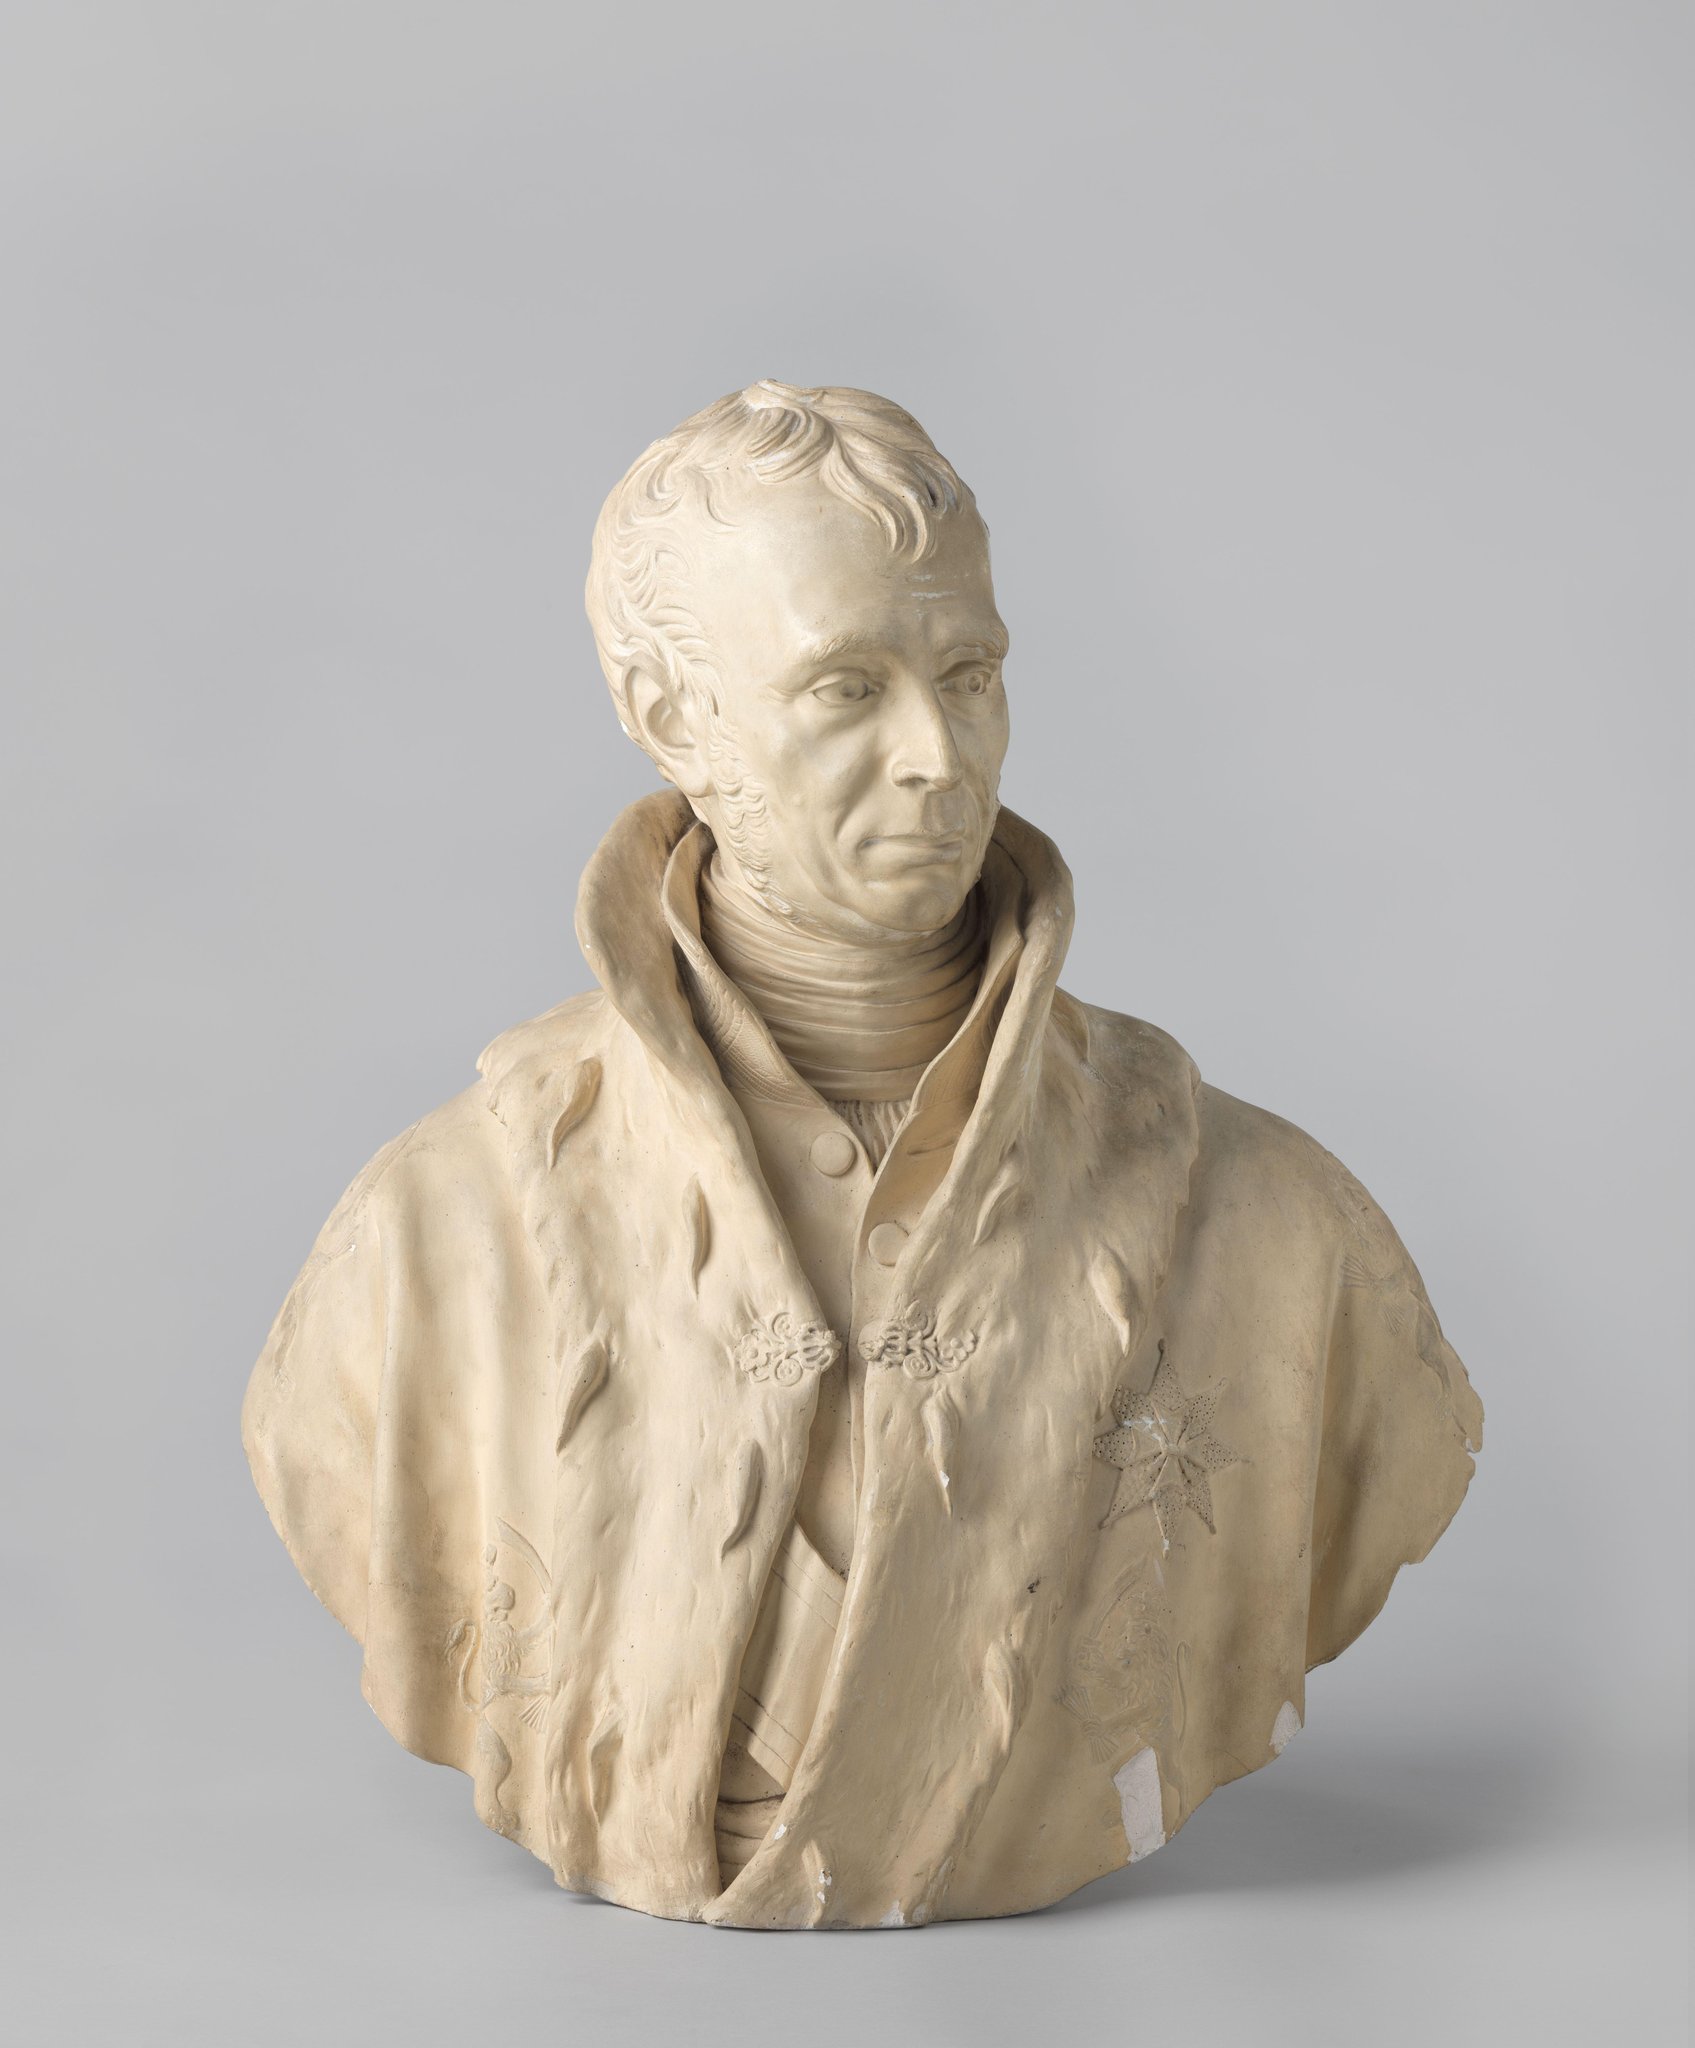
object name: bust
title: Koning Willem I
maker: gilles lambert godecharle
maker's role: sculptor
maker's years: 1750-1835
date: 1815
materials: gypsum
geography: netherlands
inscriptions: signature and date: ‘Godecharle ft 1815’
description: Buste van Koning Willem I met de koninklijke mantel. Gemerkt: Godecharle ft 1815.